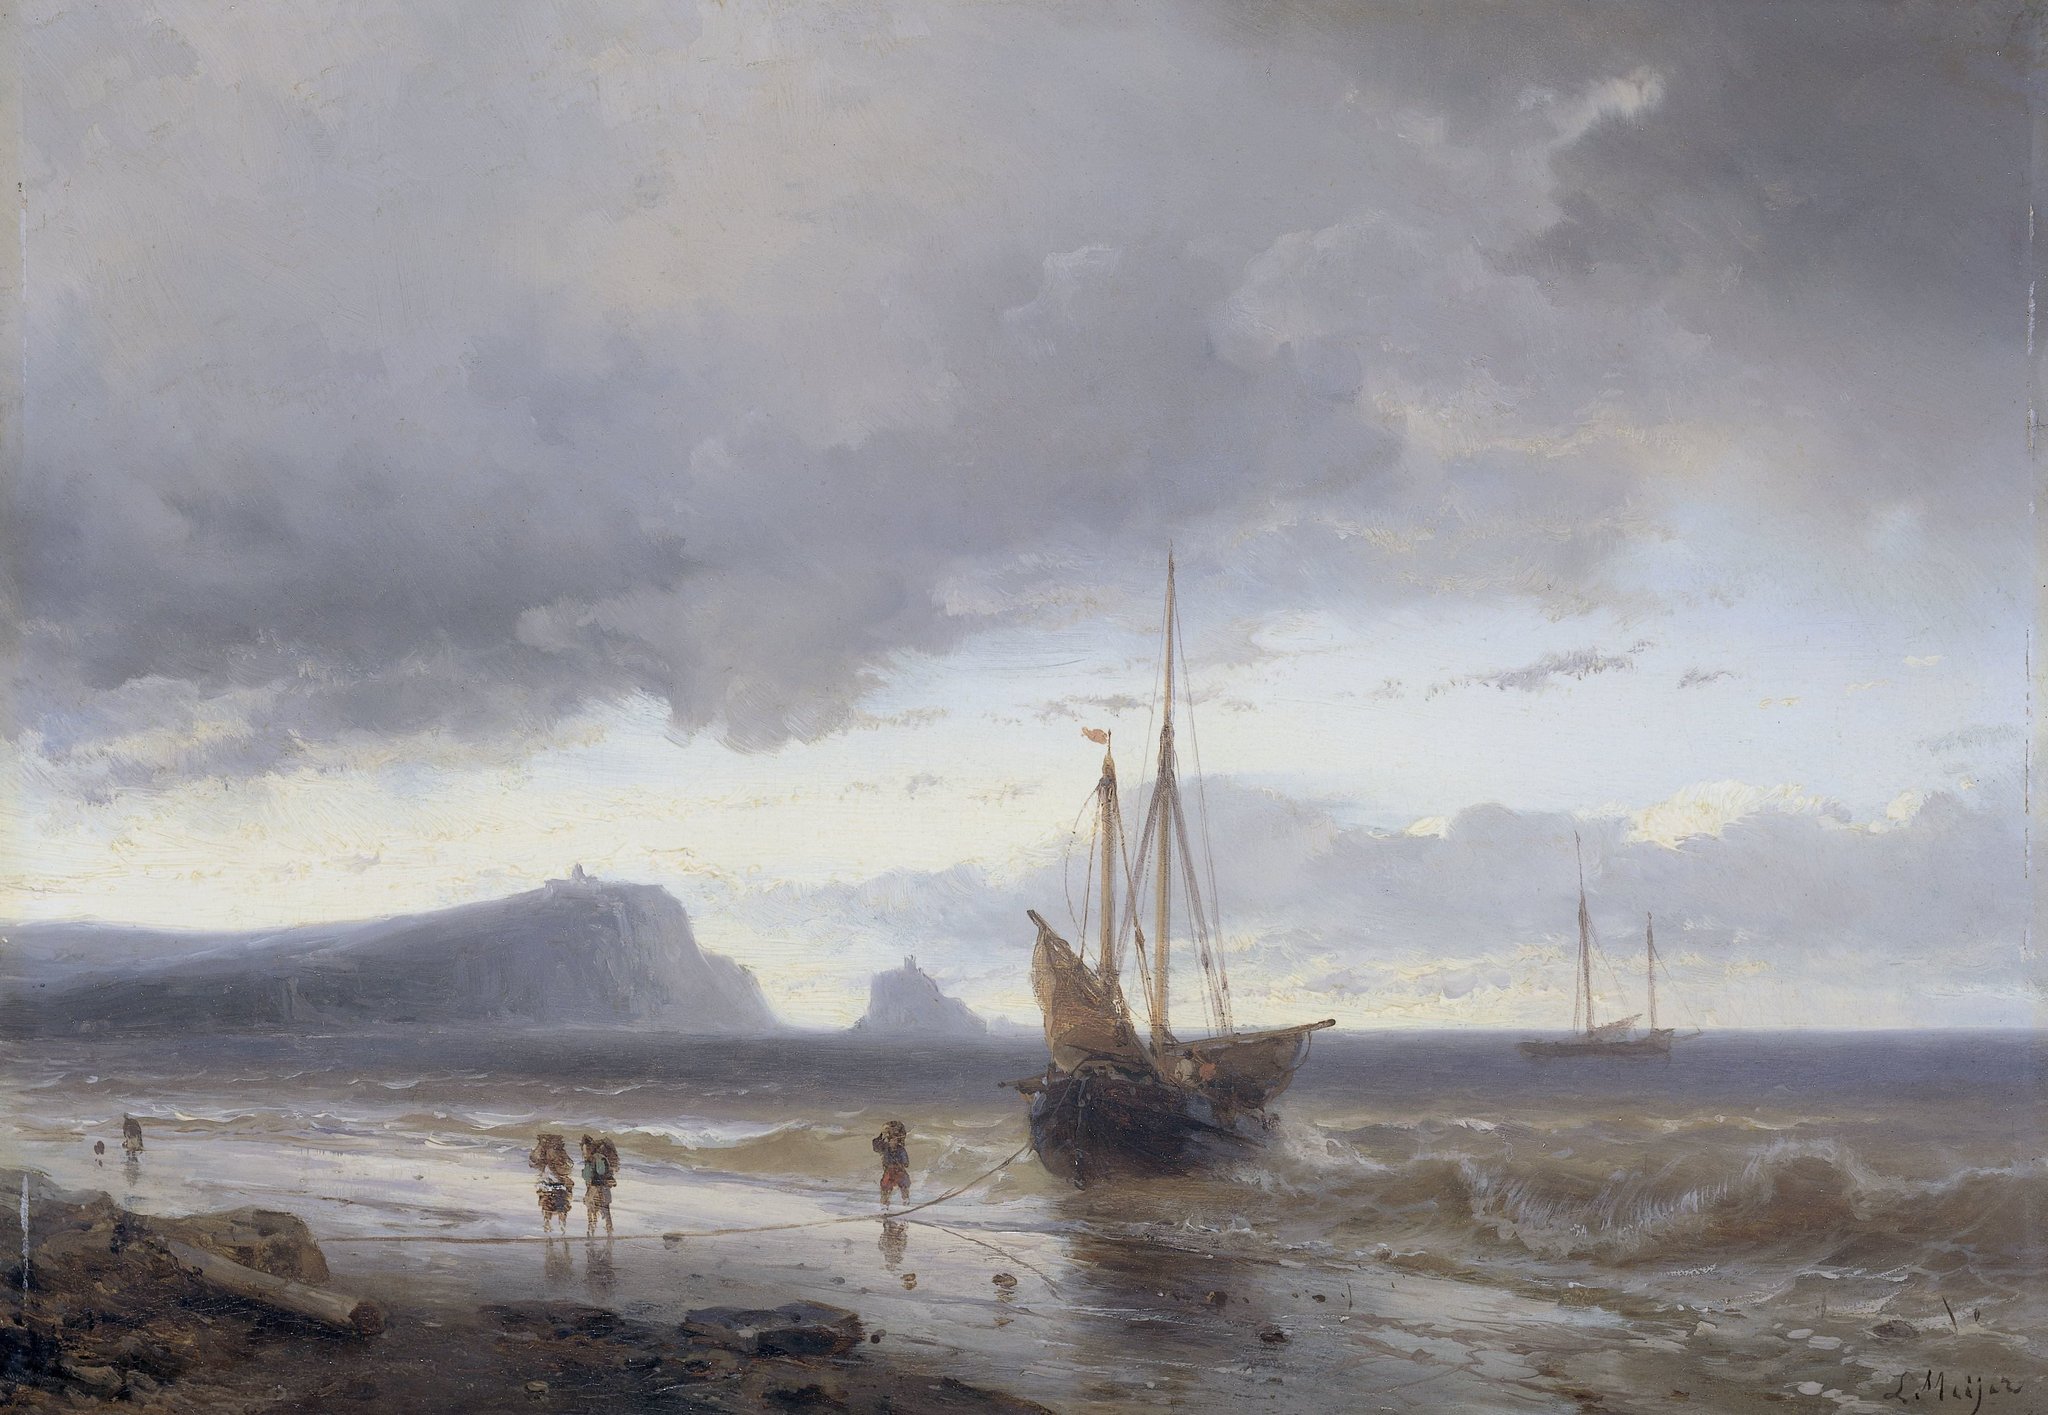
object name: painting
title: Along the Coast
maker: louis meijer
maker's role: draughtsman, painter, print maker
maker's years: 1809-1866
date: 1840-1850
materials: oil, panel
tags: sailing-ship, sailing-boat, coast, beach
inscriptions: signature: ‘L. Meijer’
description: Een schip ligt voor anker langs de kust. Op het strand lopen enkele vissers. In de verte de rotsen van de kust.